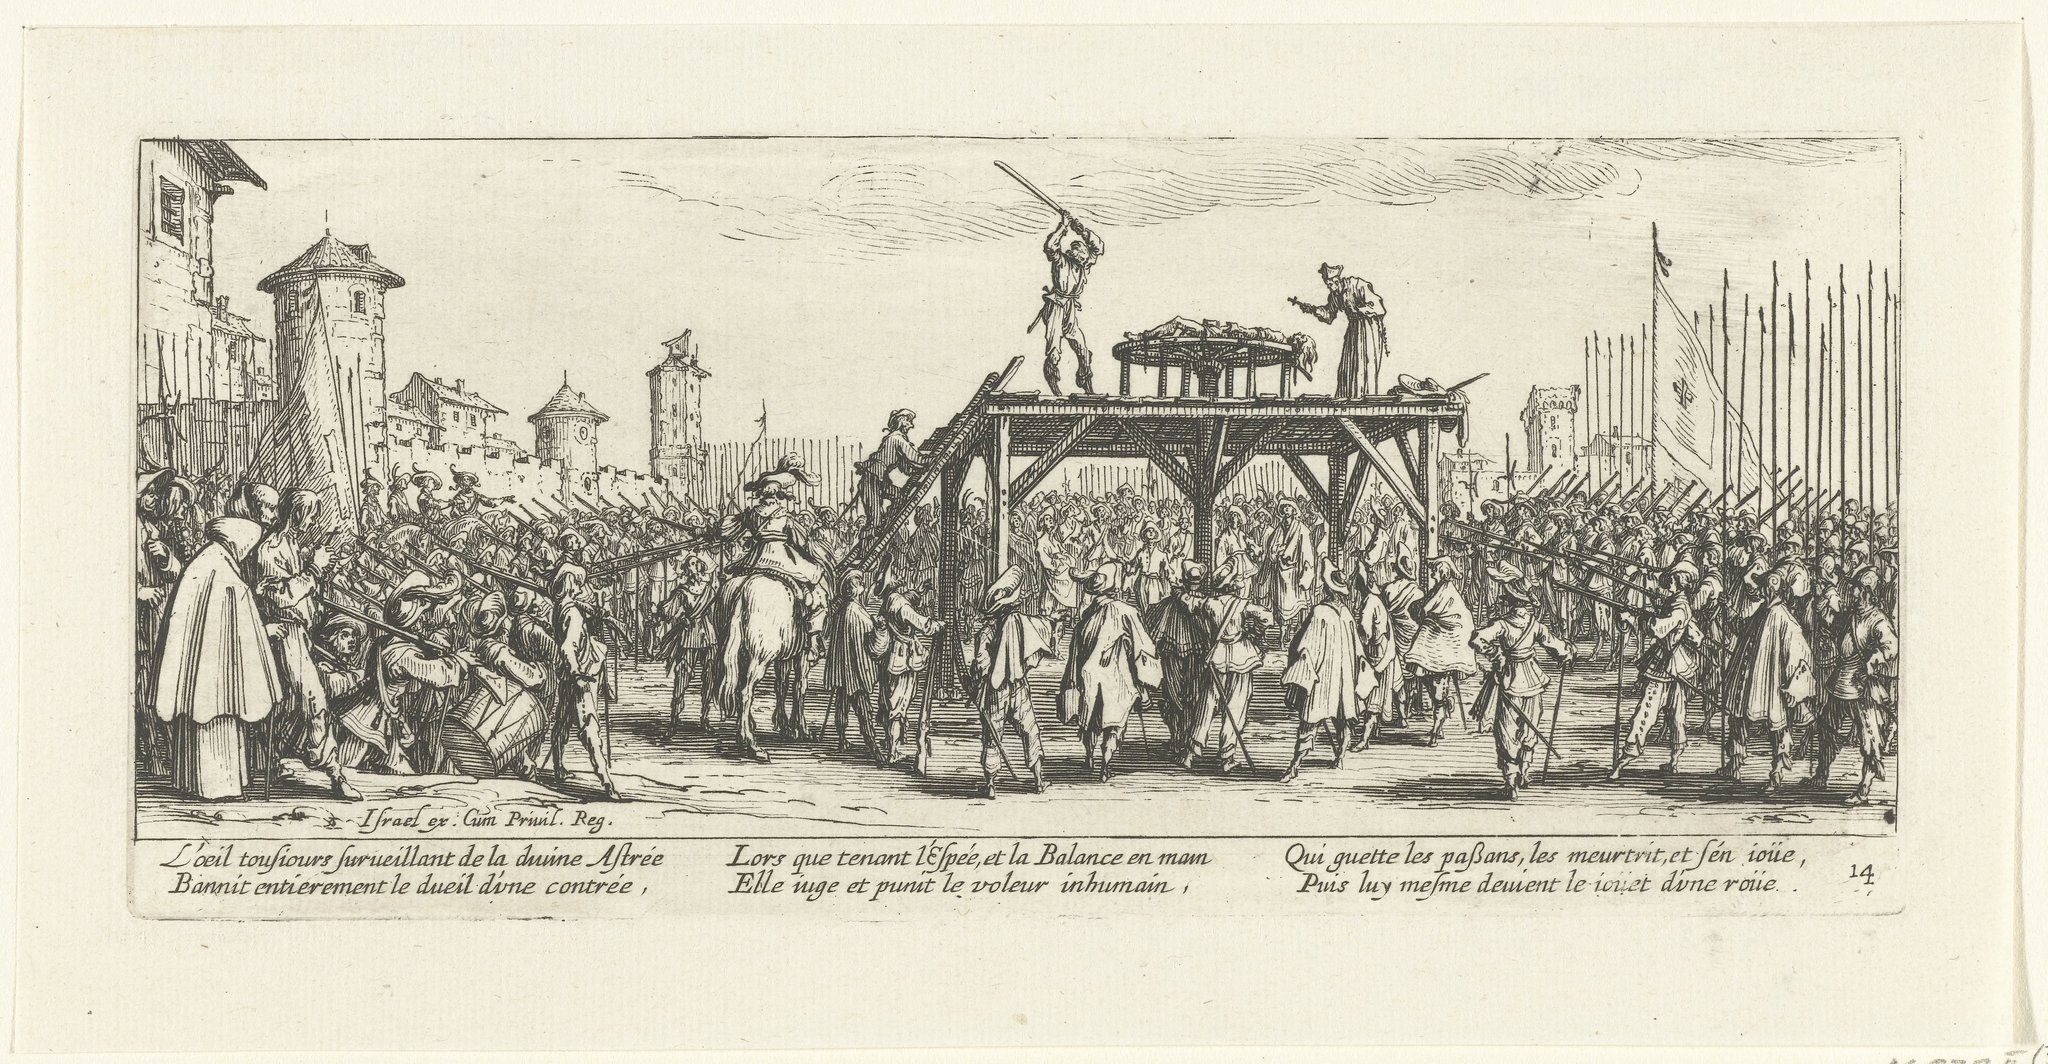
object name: print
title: Strafmaatregelen: radbraken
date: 1633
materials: paper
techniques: etching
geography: nancy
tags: physical punishment ~ military service, warfare; military affairs (+ outside city-wall or fortress)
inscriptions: collector's mark: Lugt 240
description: Op een open plek bij een stadsmuur zijn vele soldaten verzameld rond een platform waarop een man geradbraakt wordt. Onder de voorstelling een zesregelig Frans vers. Deze prent is onderdeel van een serie van 17 (18 incl. titelprent) prenten met voorstellingen van diverse soorten ellende die oorlogvoering met zich meebrengt.